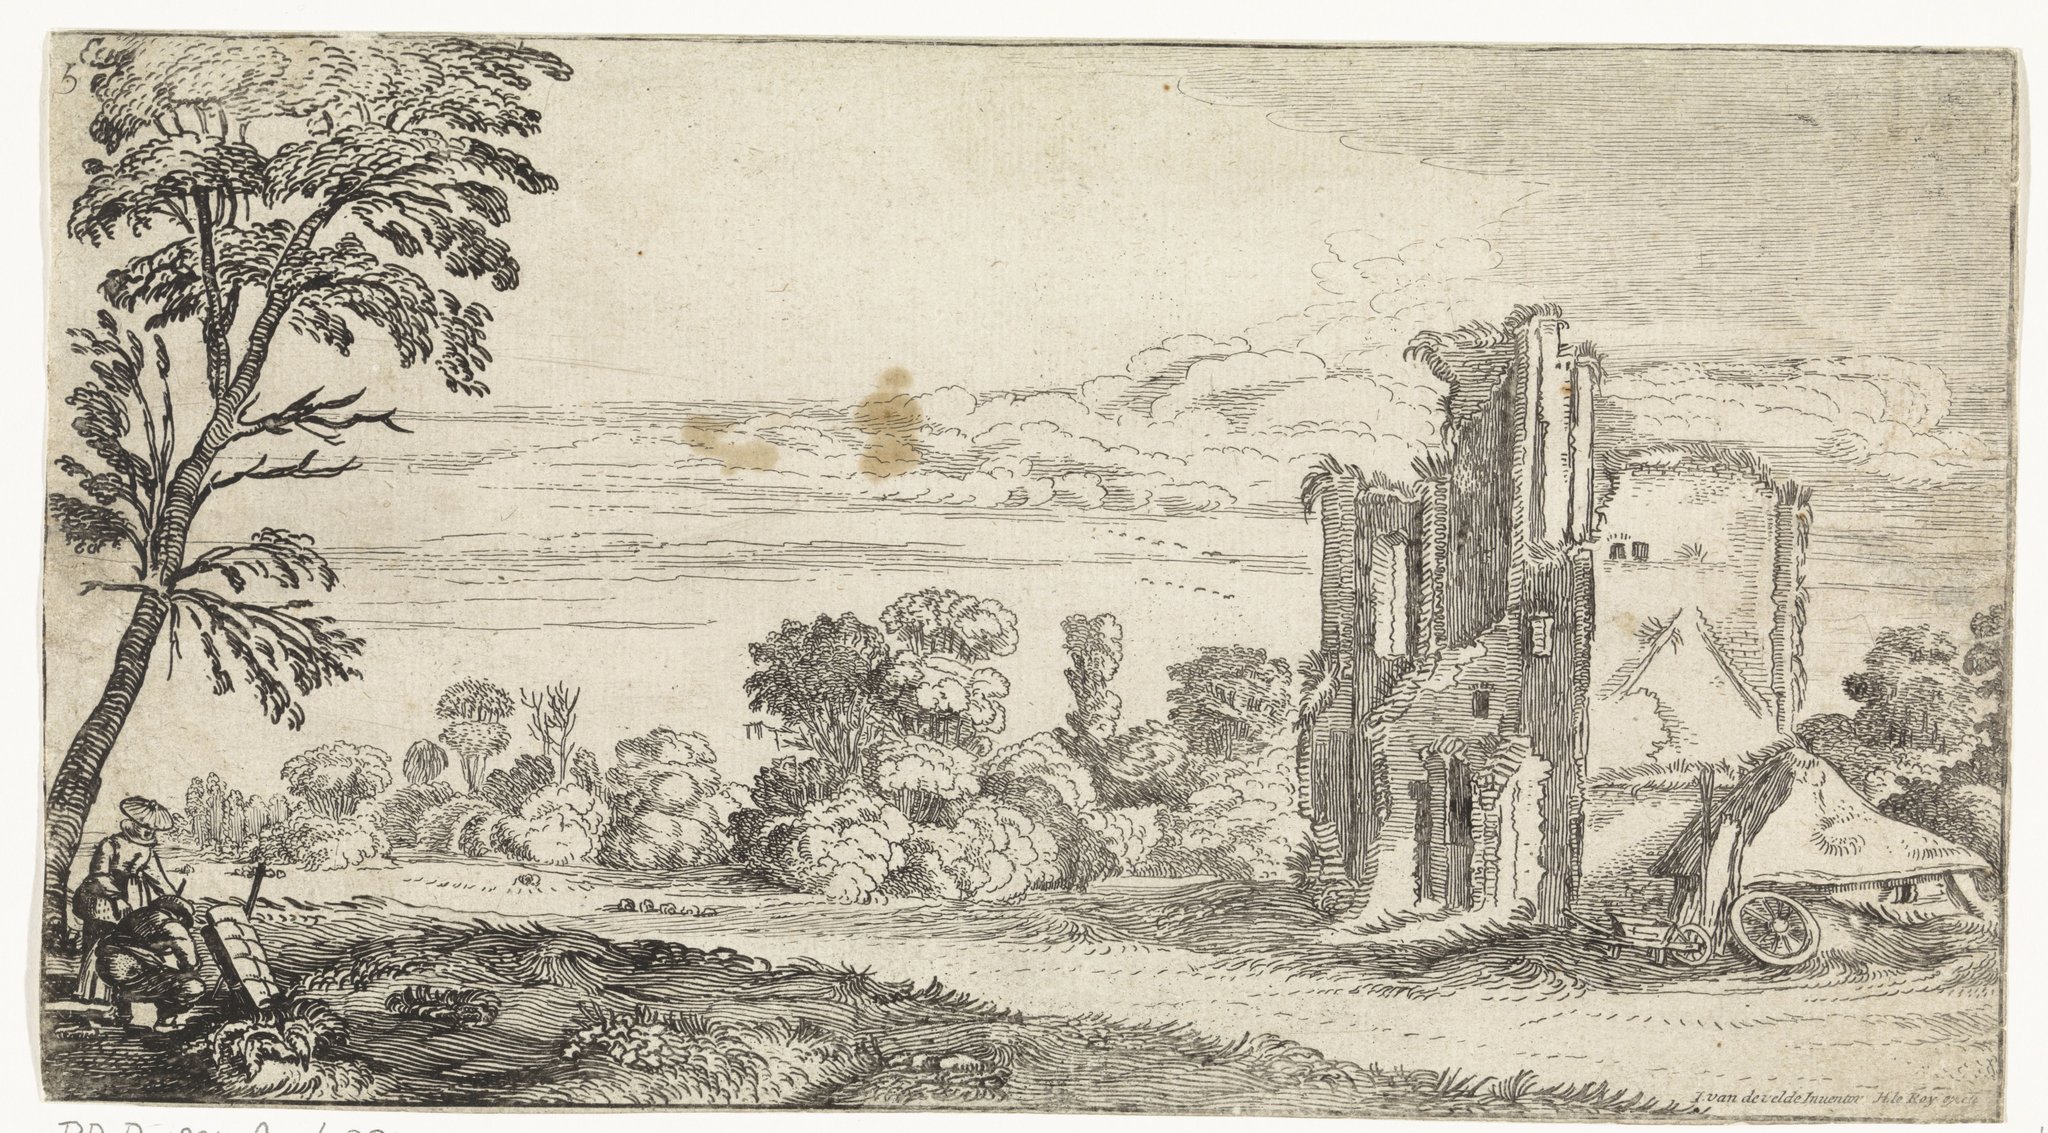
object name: print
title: Landschappen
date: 1602-1649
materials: paper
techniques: etching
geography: amsterdam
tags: defecation, ruin of a dwelling, house, castle, etc.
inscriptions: collector's mark: Lugt 2228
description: In een vlak landschap staat een kasteelruïne met daarnaast een rietgedekt boerenhuisje. Op de voorgrond een vrouw en een zich ontlastende marskramer.